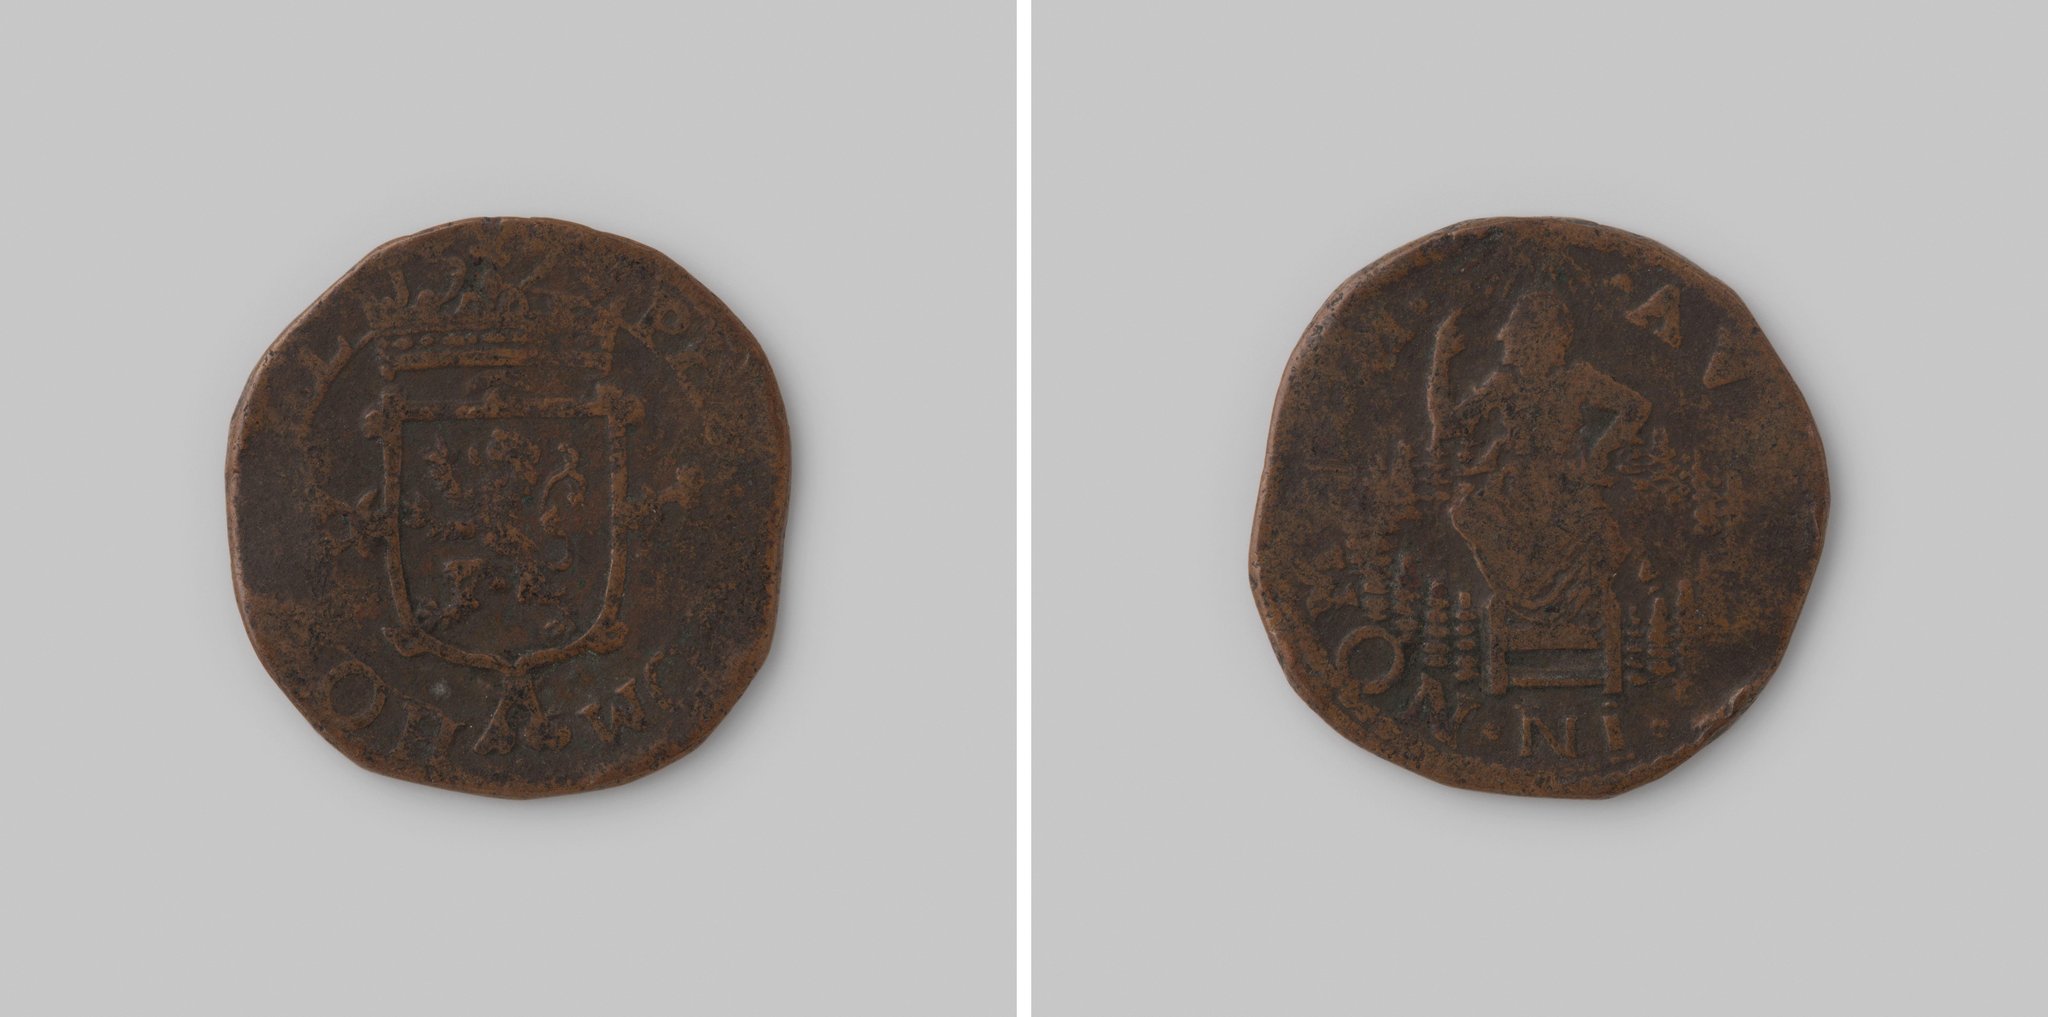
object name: oord, oortje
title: Holland, oord op naam van Philips II, 1573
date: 1573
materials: copper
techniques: striking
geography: dordrecht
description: Koperen munt. Voorzijde: gekroond wapenschild van Holland op stokkenkruis. In omschrift naam van Philips II en jaartal. Keerzijde: Hollandse maagd met opgestoken rechterarm, zittend in een tuin met gesloten omheining.